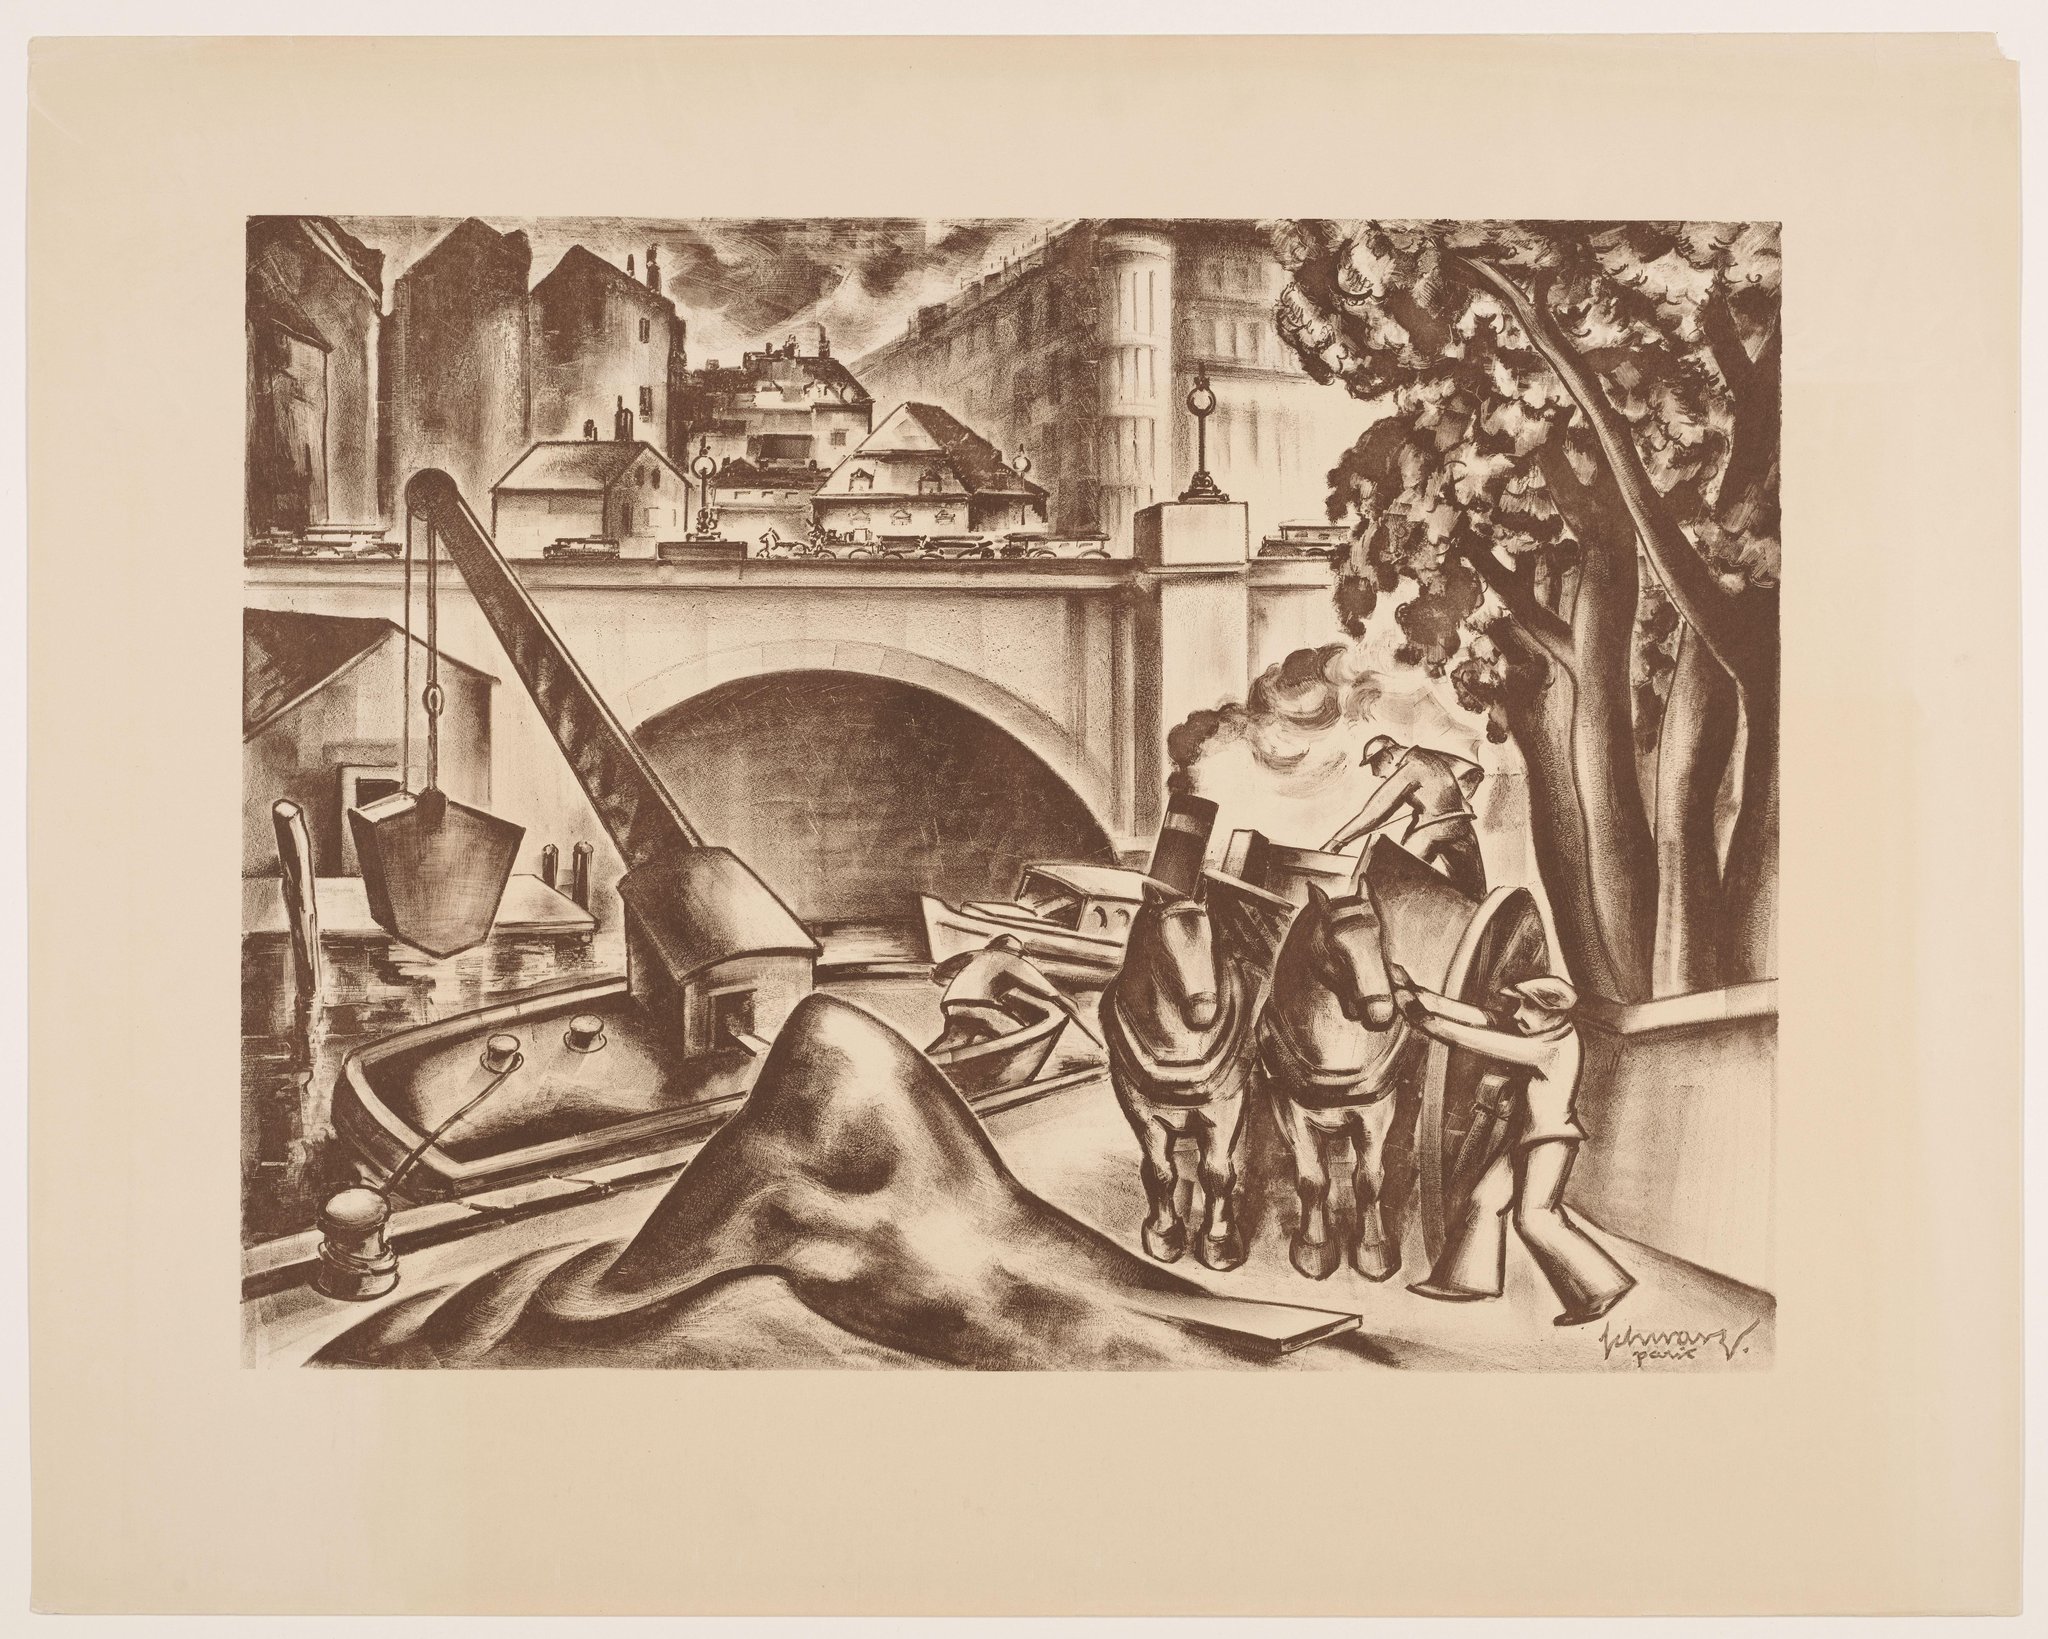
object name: print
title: Kade van de Seine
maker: mommie schwarz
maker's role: print maker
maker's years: 1876-1942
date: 1909-1910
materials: paper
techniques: lithograph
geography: paris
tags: trees, horse, bridge in city across river, canal, etc., paris